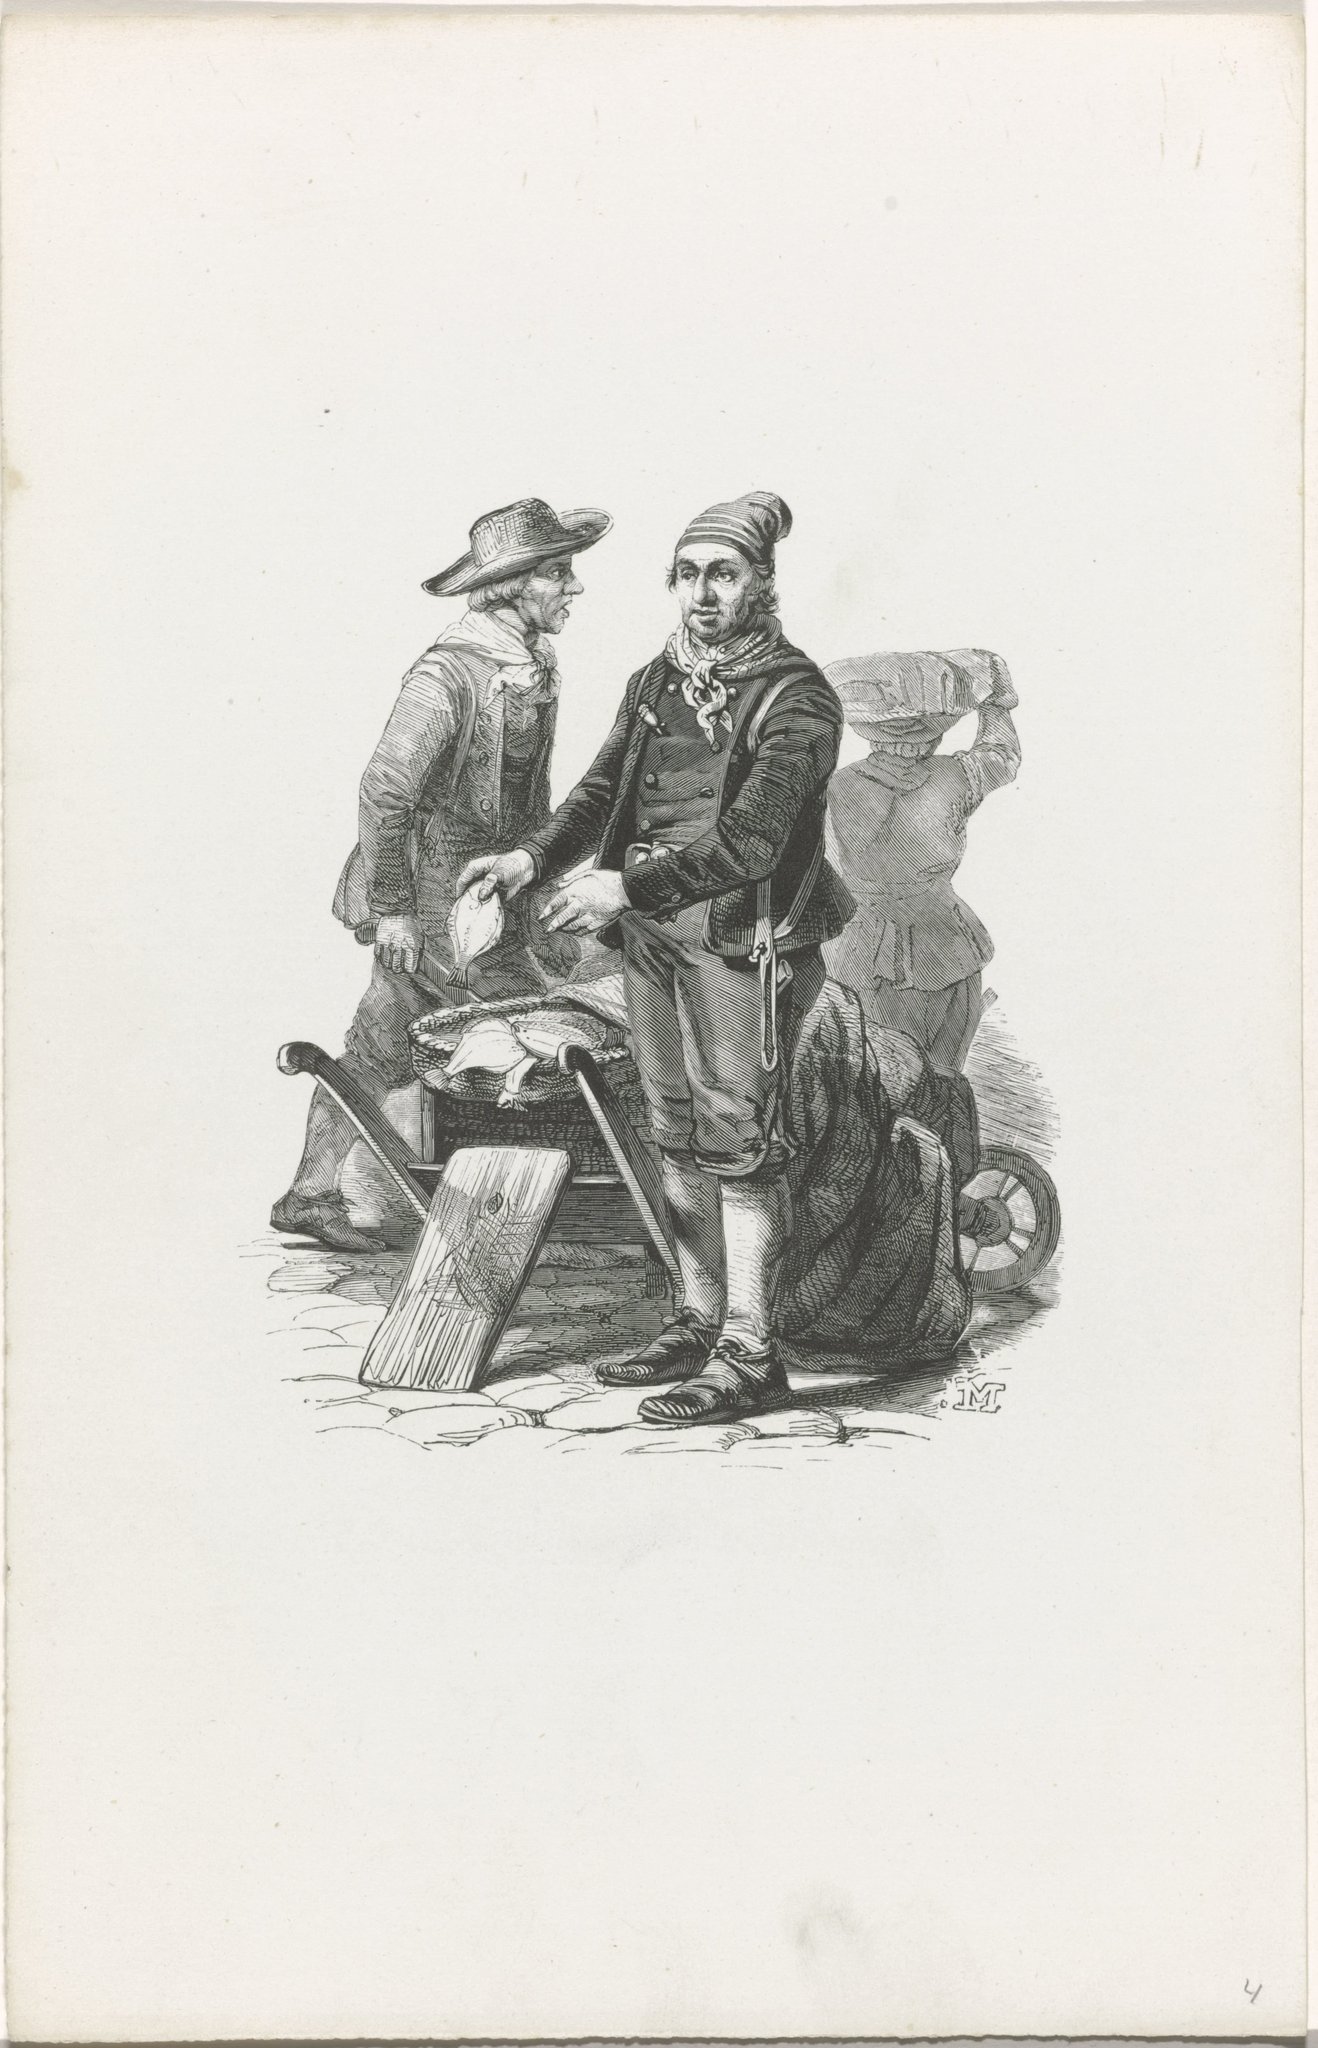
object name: costume print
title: De botboer, 1840-1841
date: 1840-1841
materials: paper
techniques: engraving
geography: netherlands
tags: commercial fishery, professional clothes, stall, booth (~ market), persons engaged in trade and commerce, netherlands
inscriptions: collector's mark: Lugt 2228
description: Door Muller opgenomen als illustraties die wel gemaakt zijn voor, maar uiteindelijk niet zijn gebruikt in het boek: De Nederlanden : karakterschetsen, kleederdrachten, houding en voorkomen van verschillende standen : tekst van de meest geachte schrijvers : met gravuren van Henry Brown naar teekeningen van de voornaamste Nederlandsche kunstenaars. 's Gravenhage, 1841.